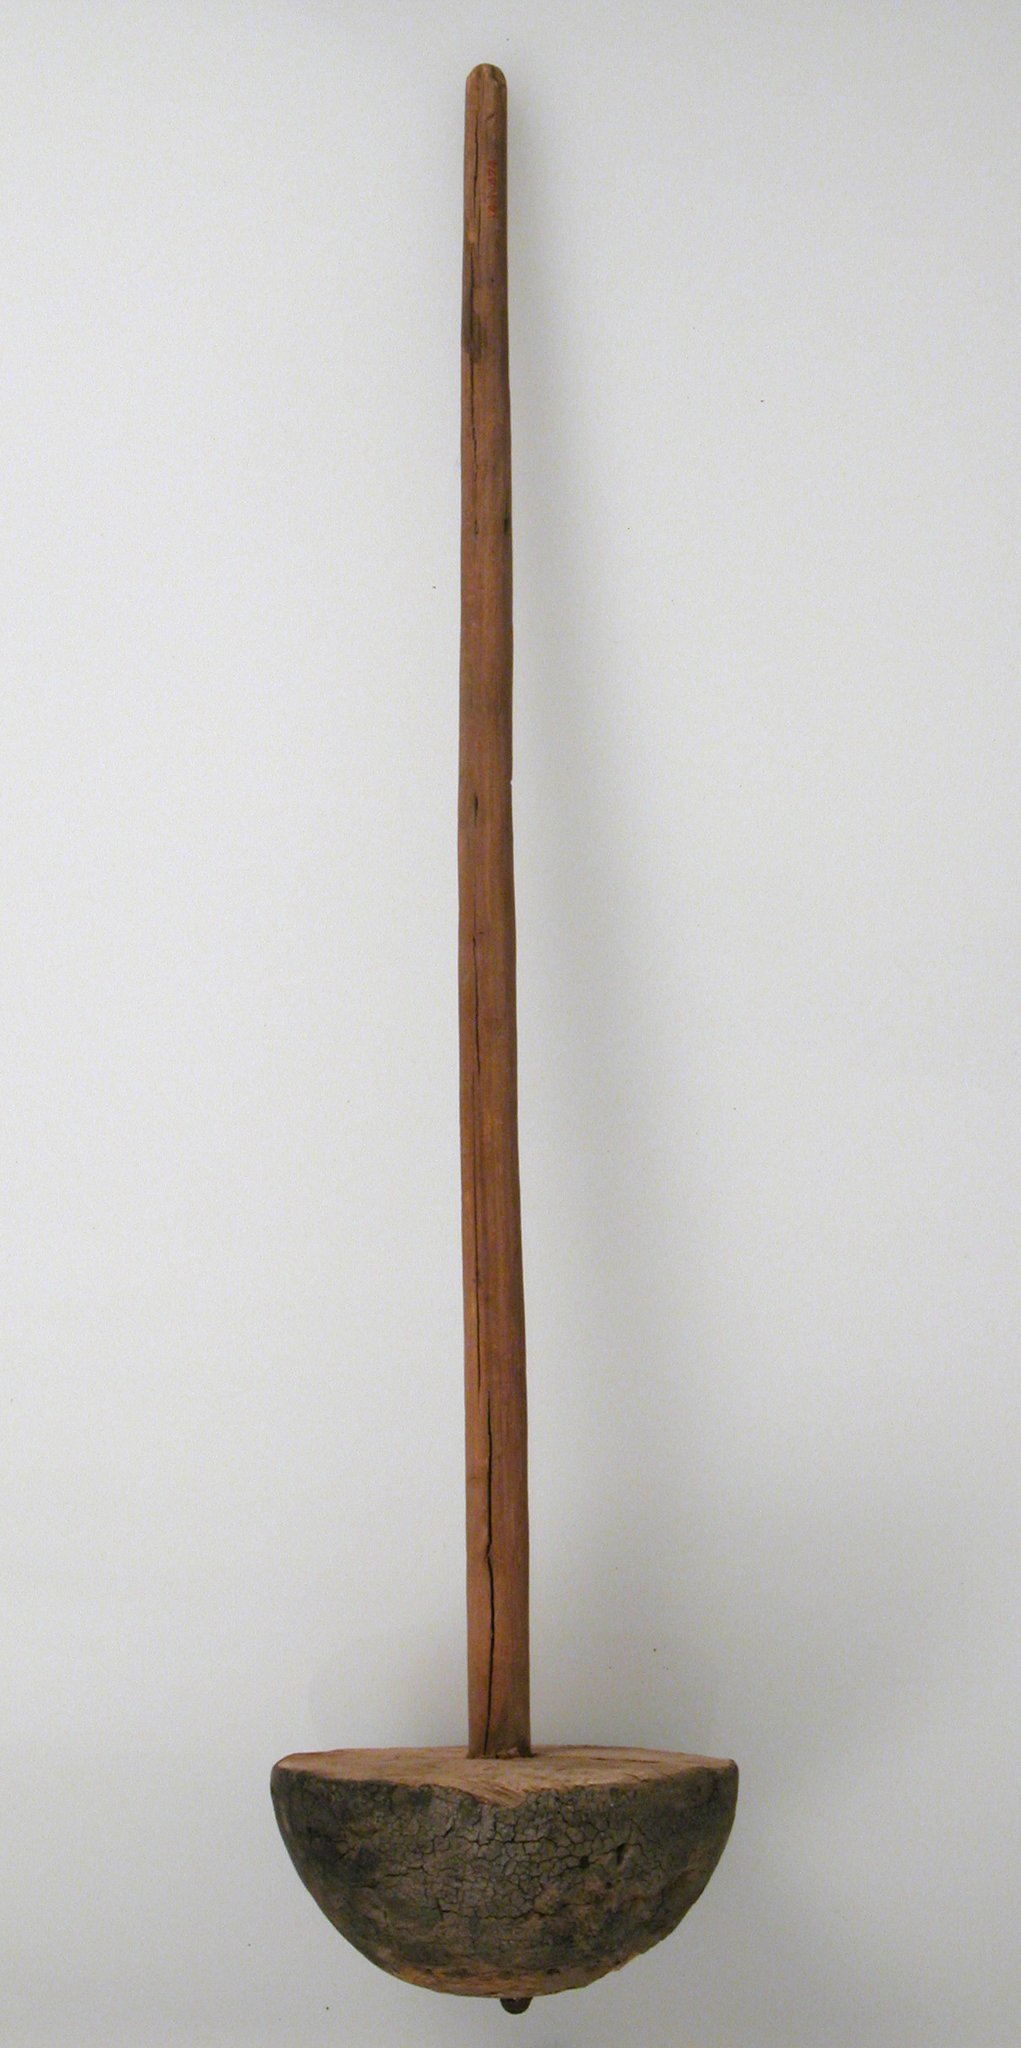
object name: spindle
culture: coptic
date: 580-640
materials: iron, wood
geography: egypt